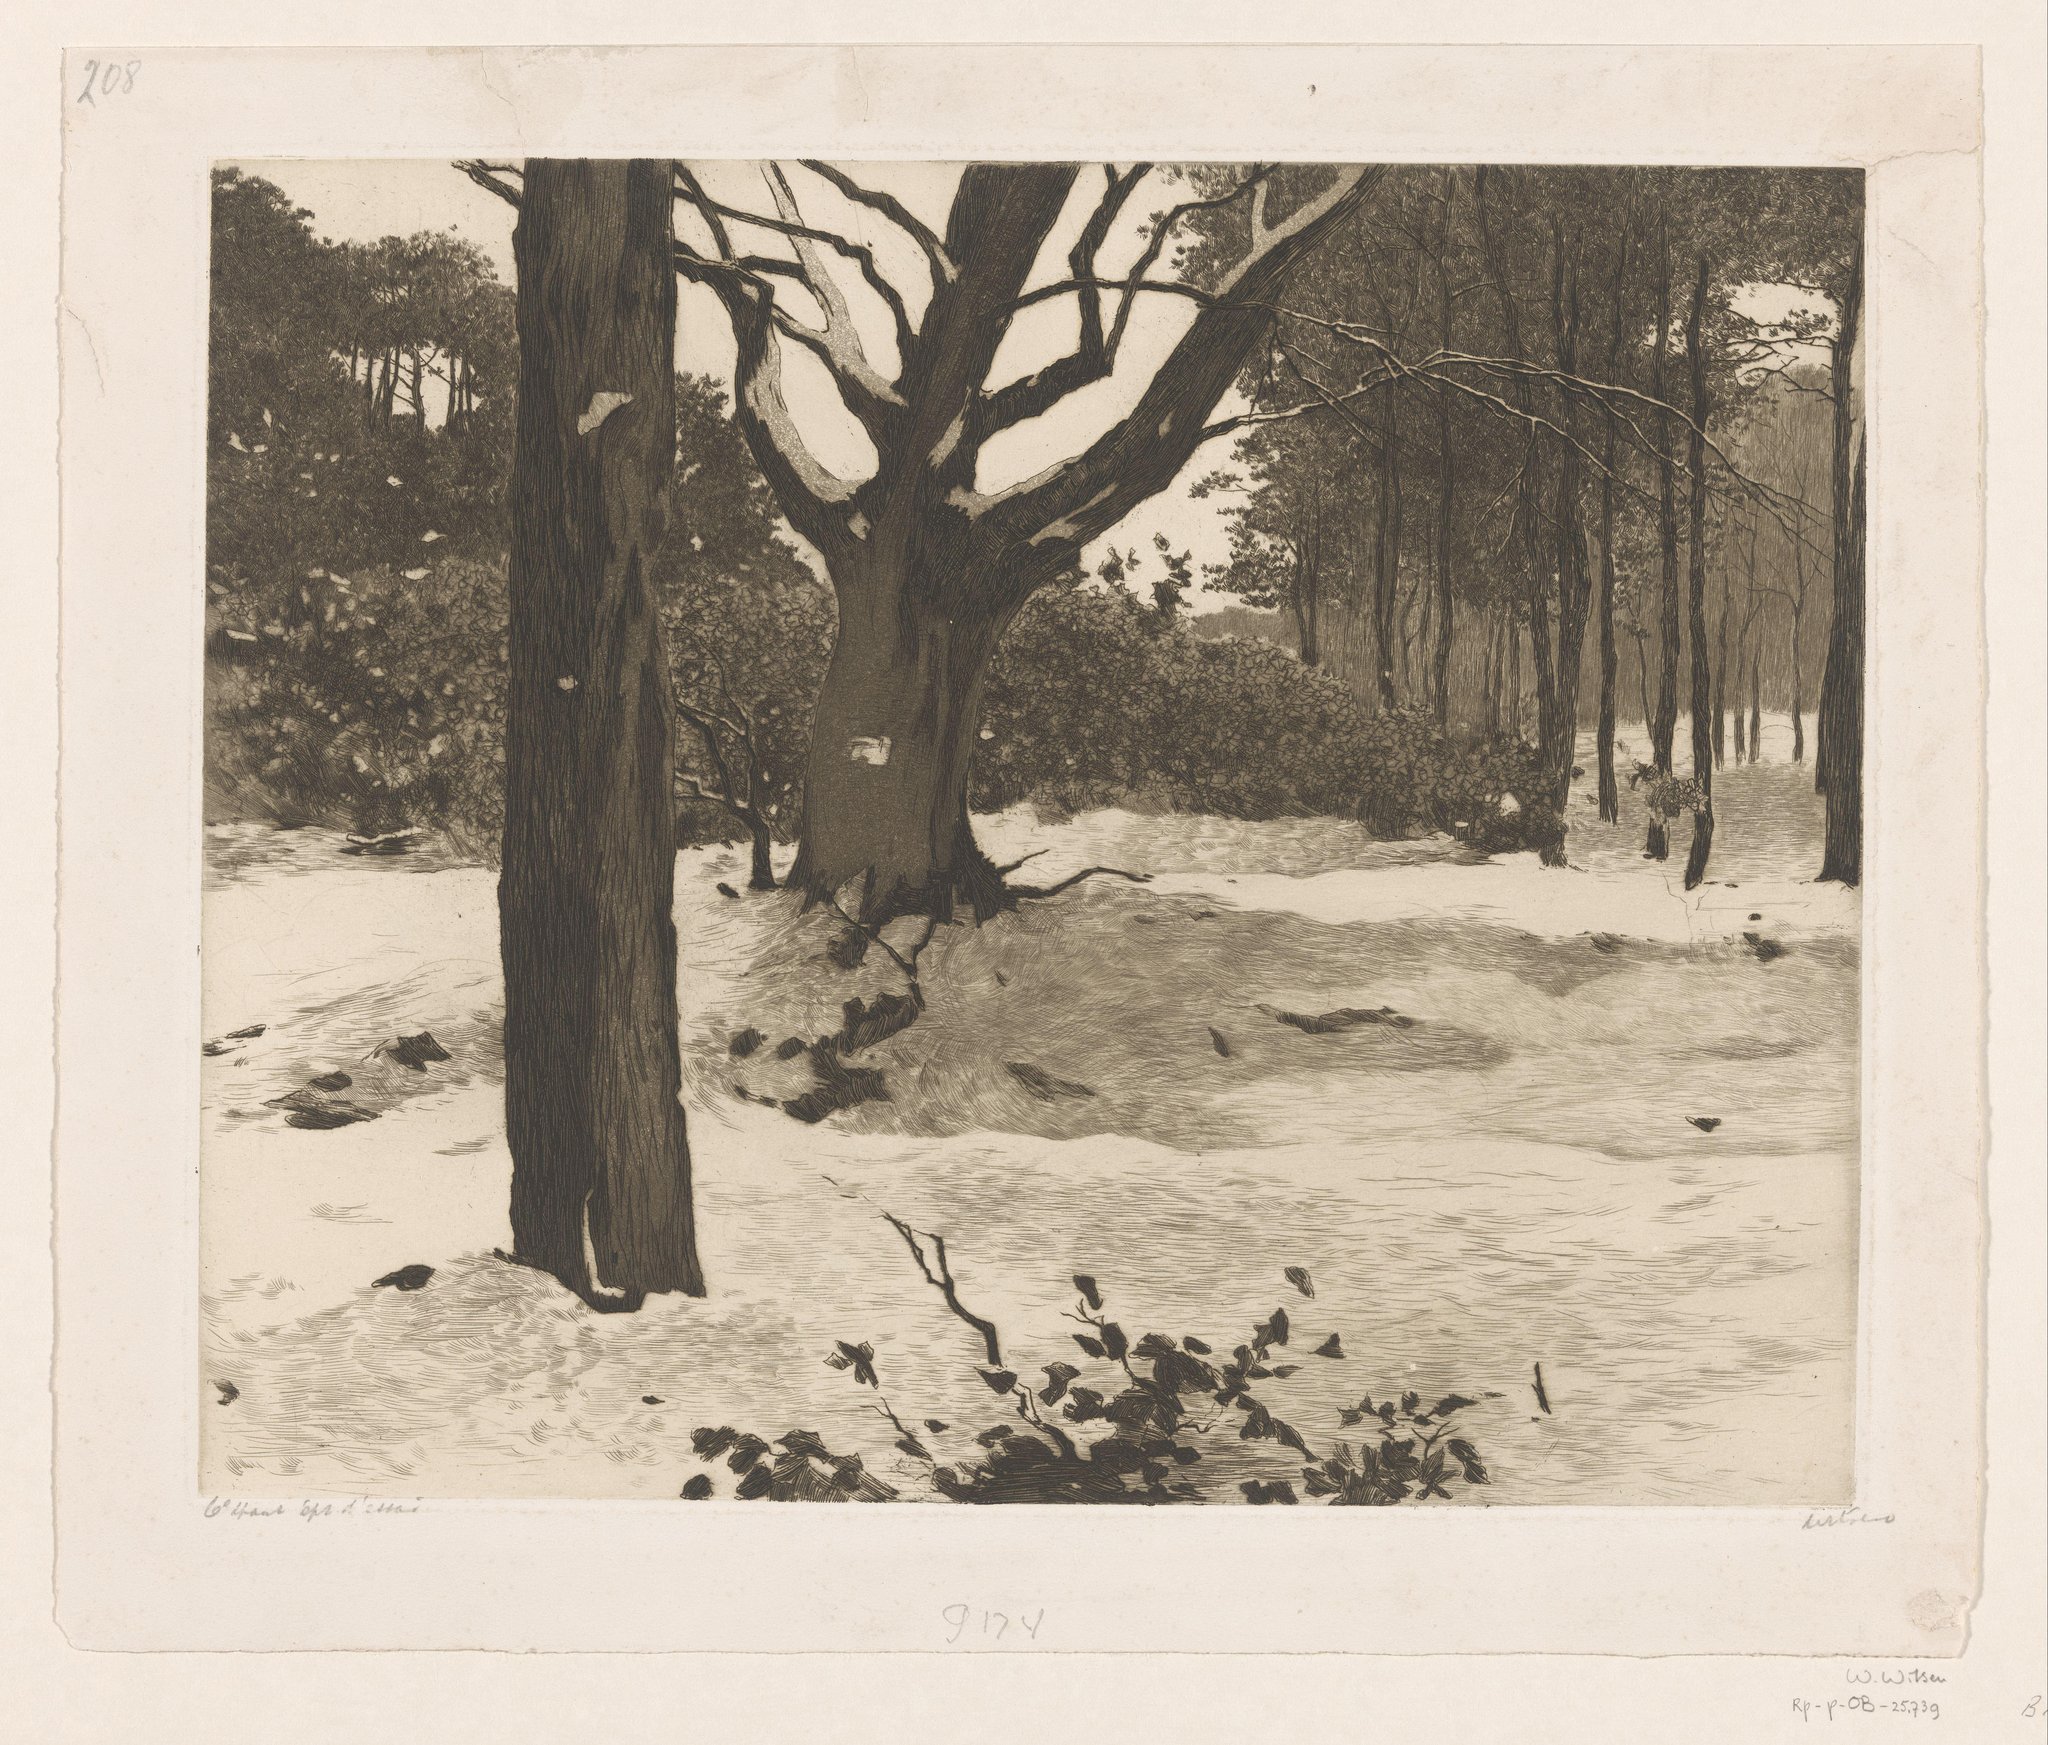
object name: print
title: Besneeuwd boslandschap in Ede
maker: willem witsen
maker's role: draughtsman, painter, print maker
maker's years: 1860-1923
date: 1906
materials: paper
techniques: aquatint, etching, intaglio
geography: amsterdam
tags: trees, snow, deciduous forest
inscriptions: collector's mark: Lugt 2228